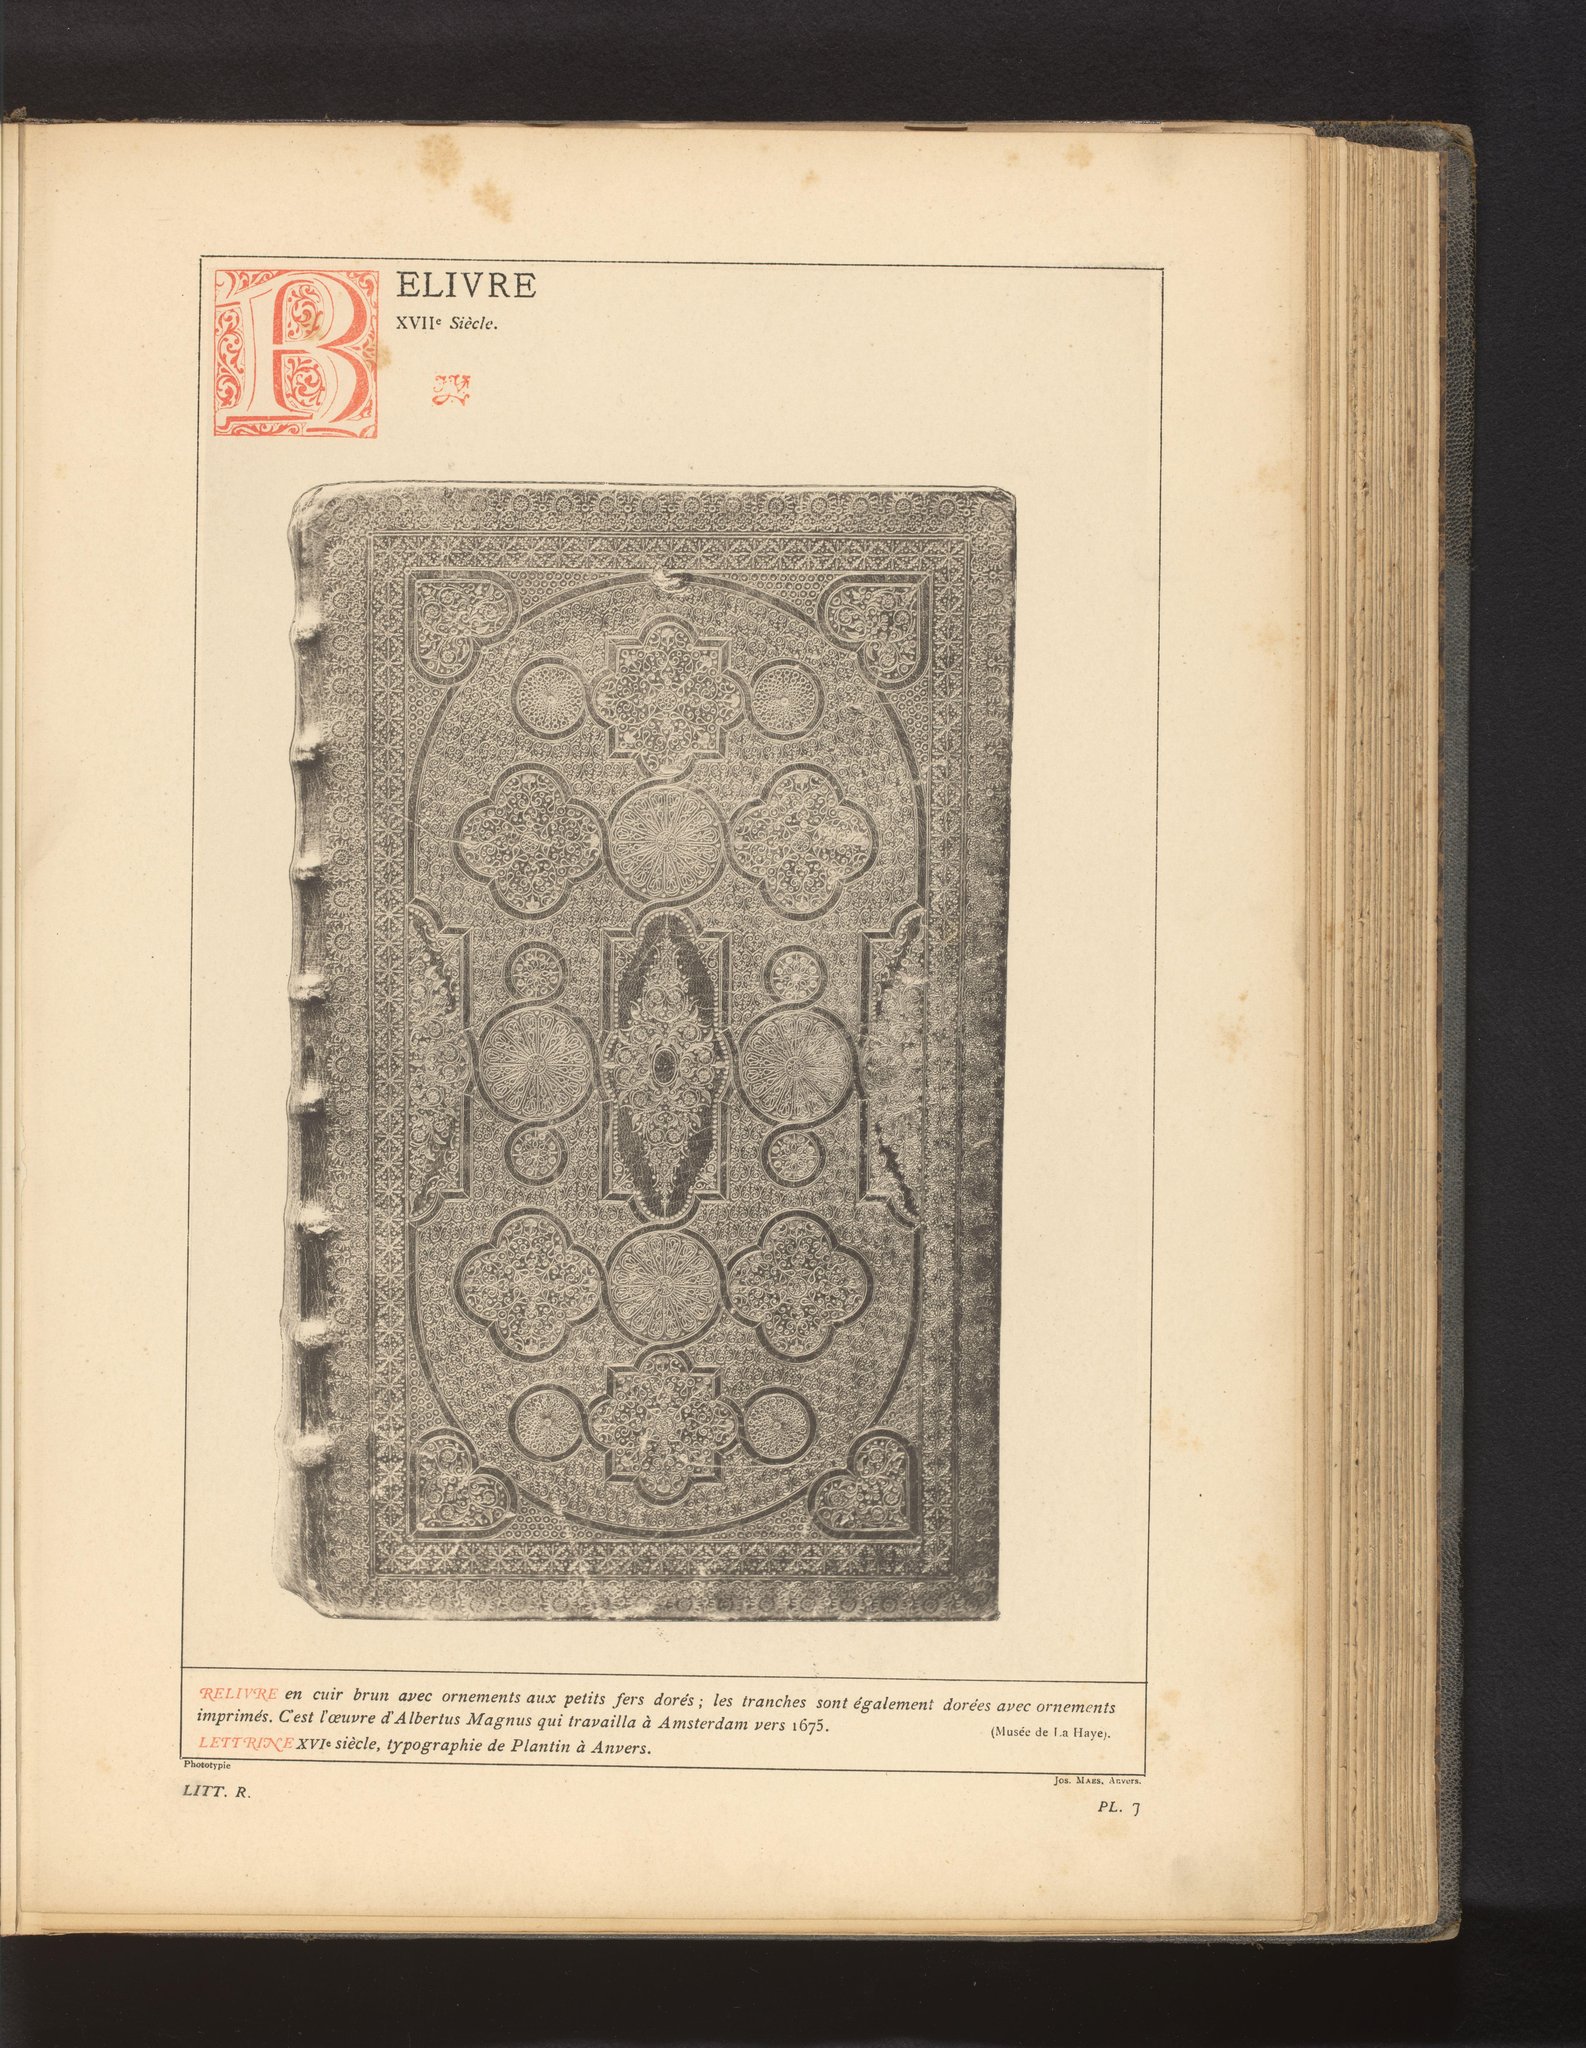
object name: page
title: Gedecoreerde boekband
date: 1876-1881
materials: paper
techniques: photograph, photolithography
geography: antwerp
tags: book-cover, binding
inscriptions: monogram: ‘JJvY’, inscription: ‘RELIURE en cuir (...)’, inscription: ‘LITT. R. - PL. 7.’